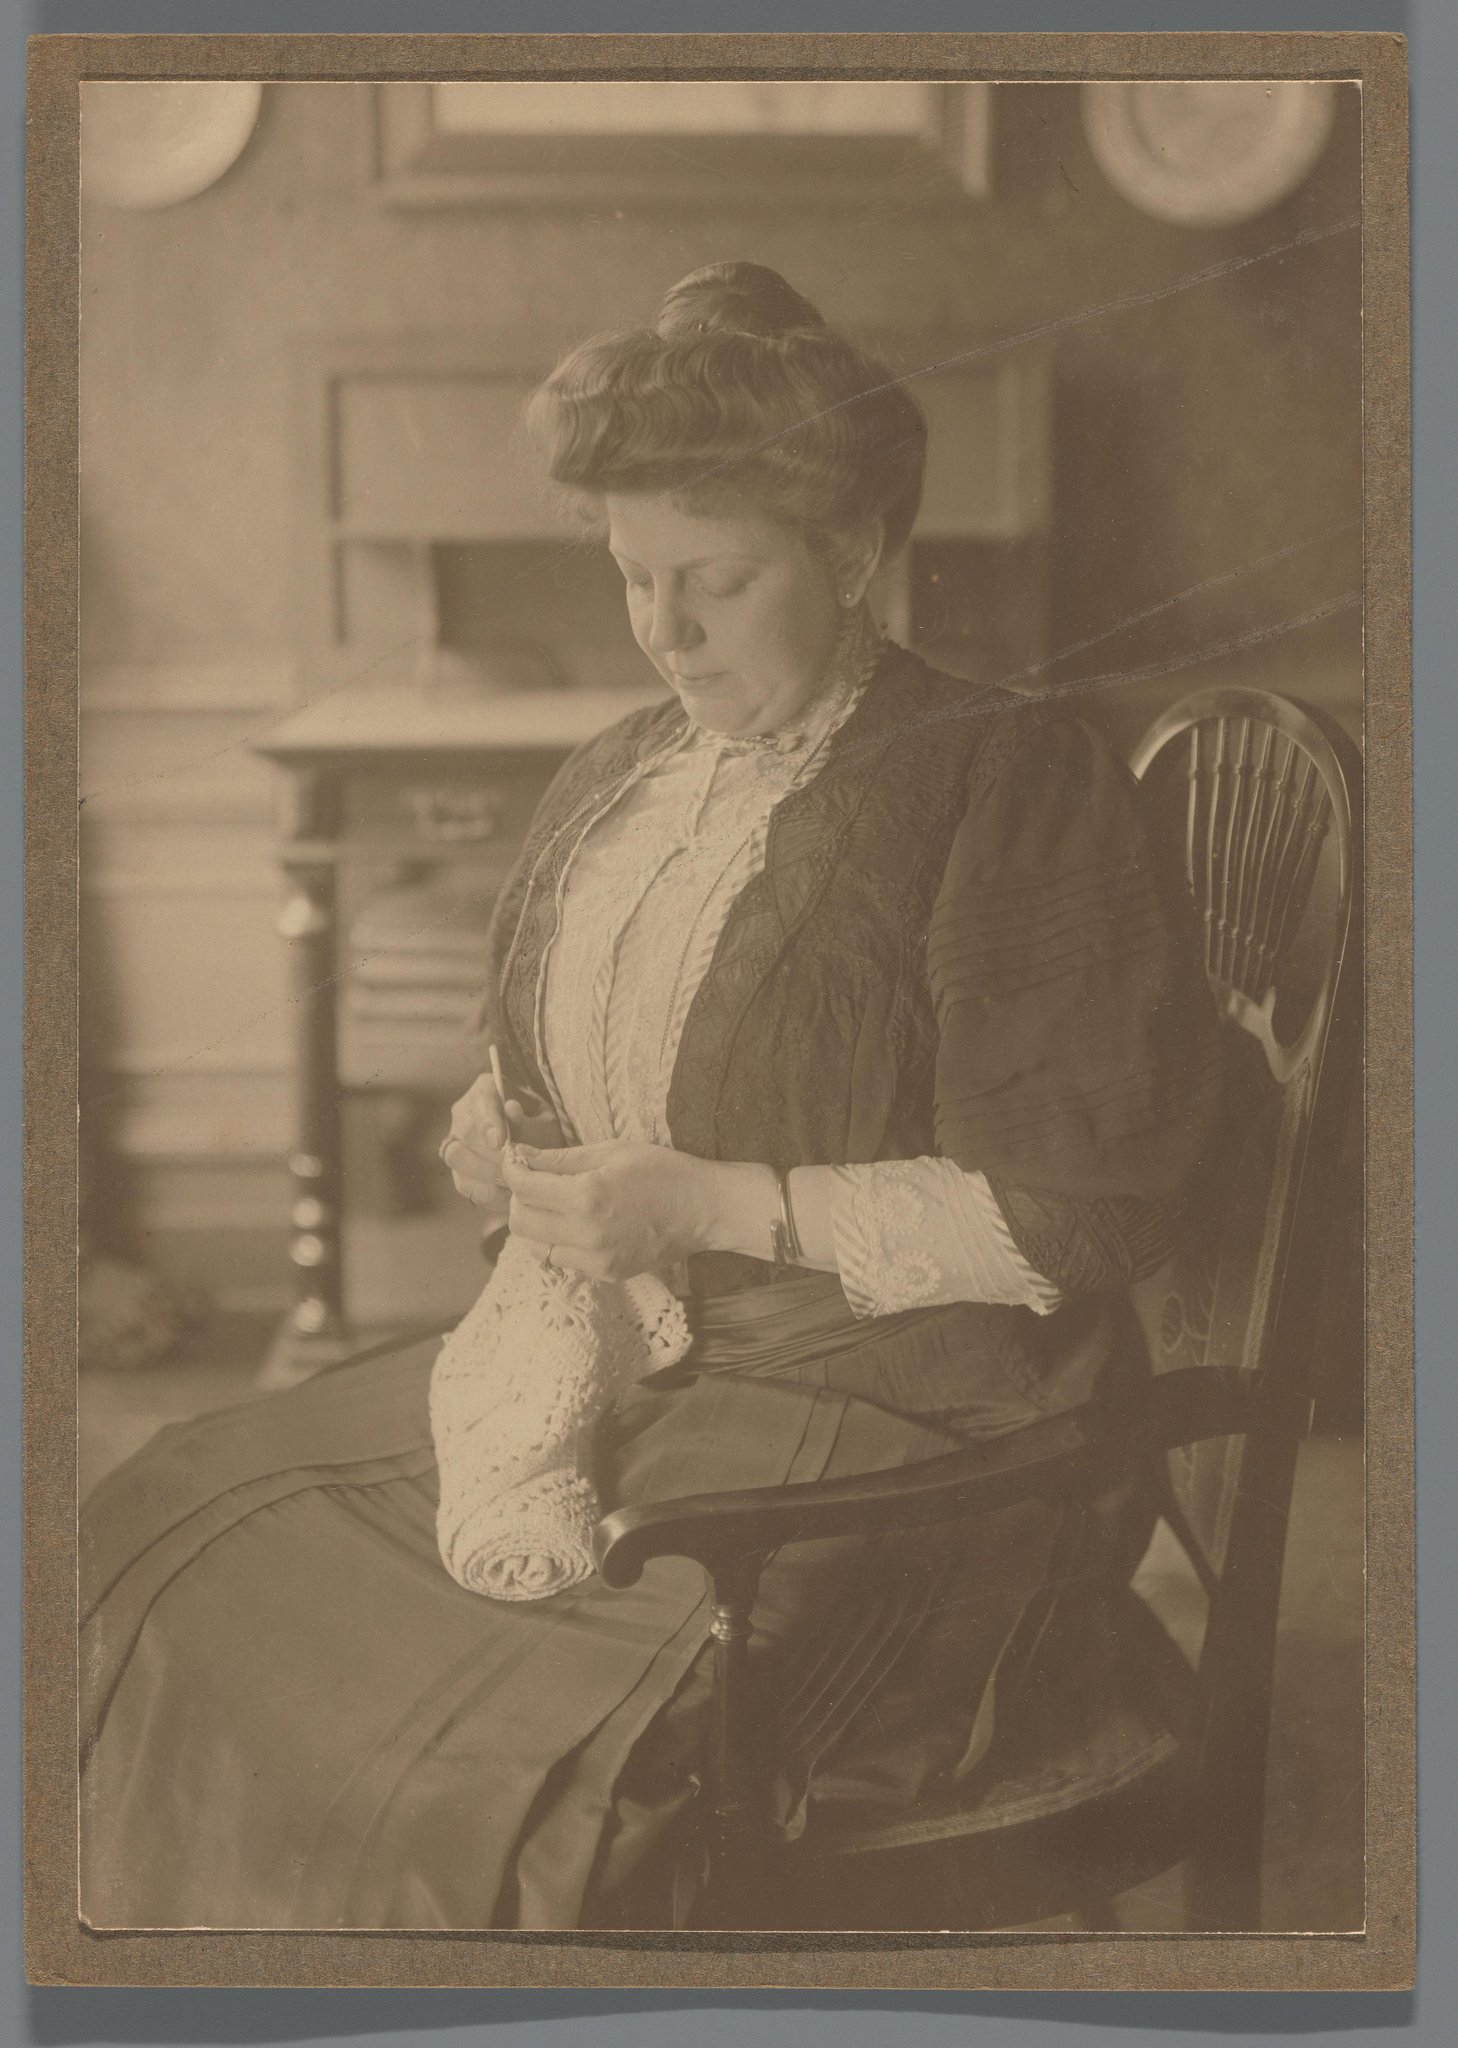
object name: photograph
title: Portret van Pauline van den Berg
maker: Anonymous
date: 1895-1910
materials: cardboard, photographic support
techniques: albumen print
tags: batavia, the hague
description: Zittende vrouw in huiselijke omgeving met haakwerk in haar handen.